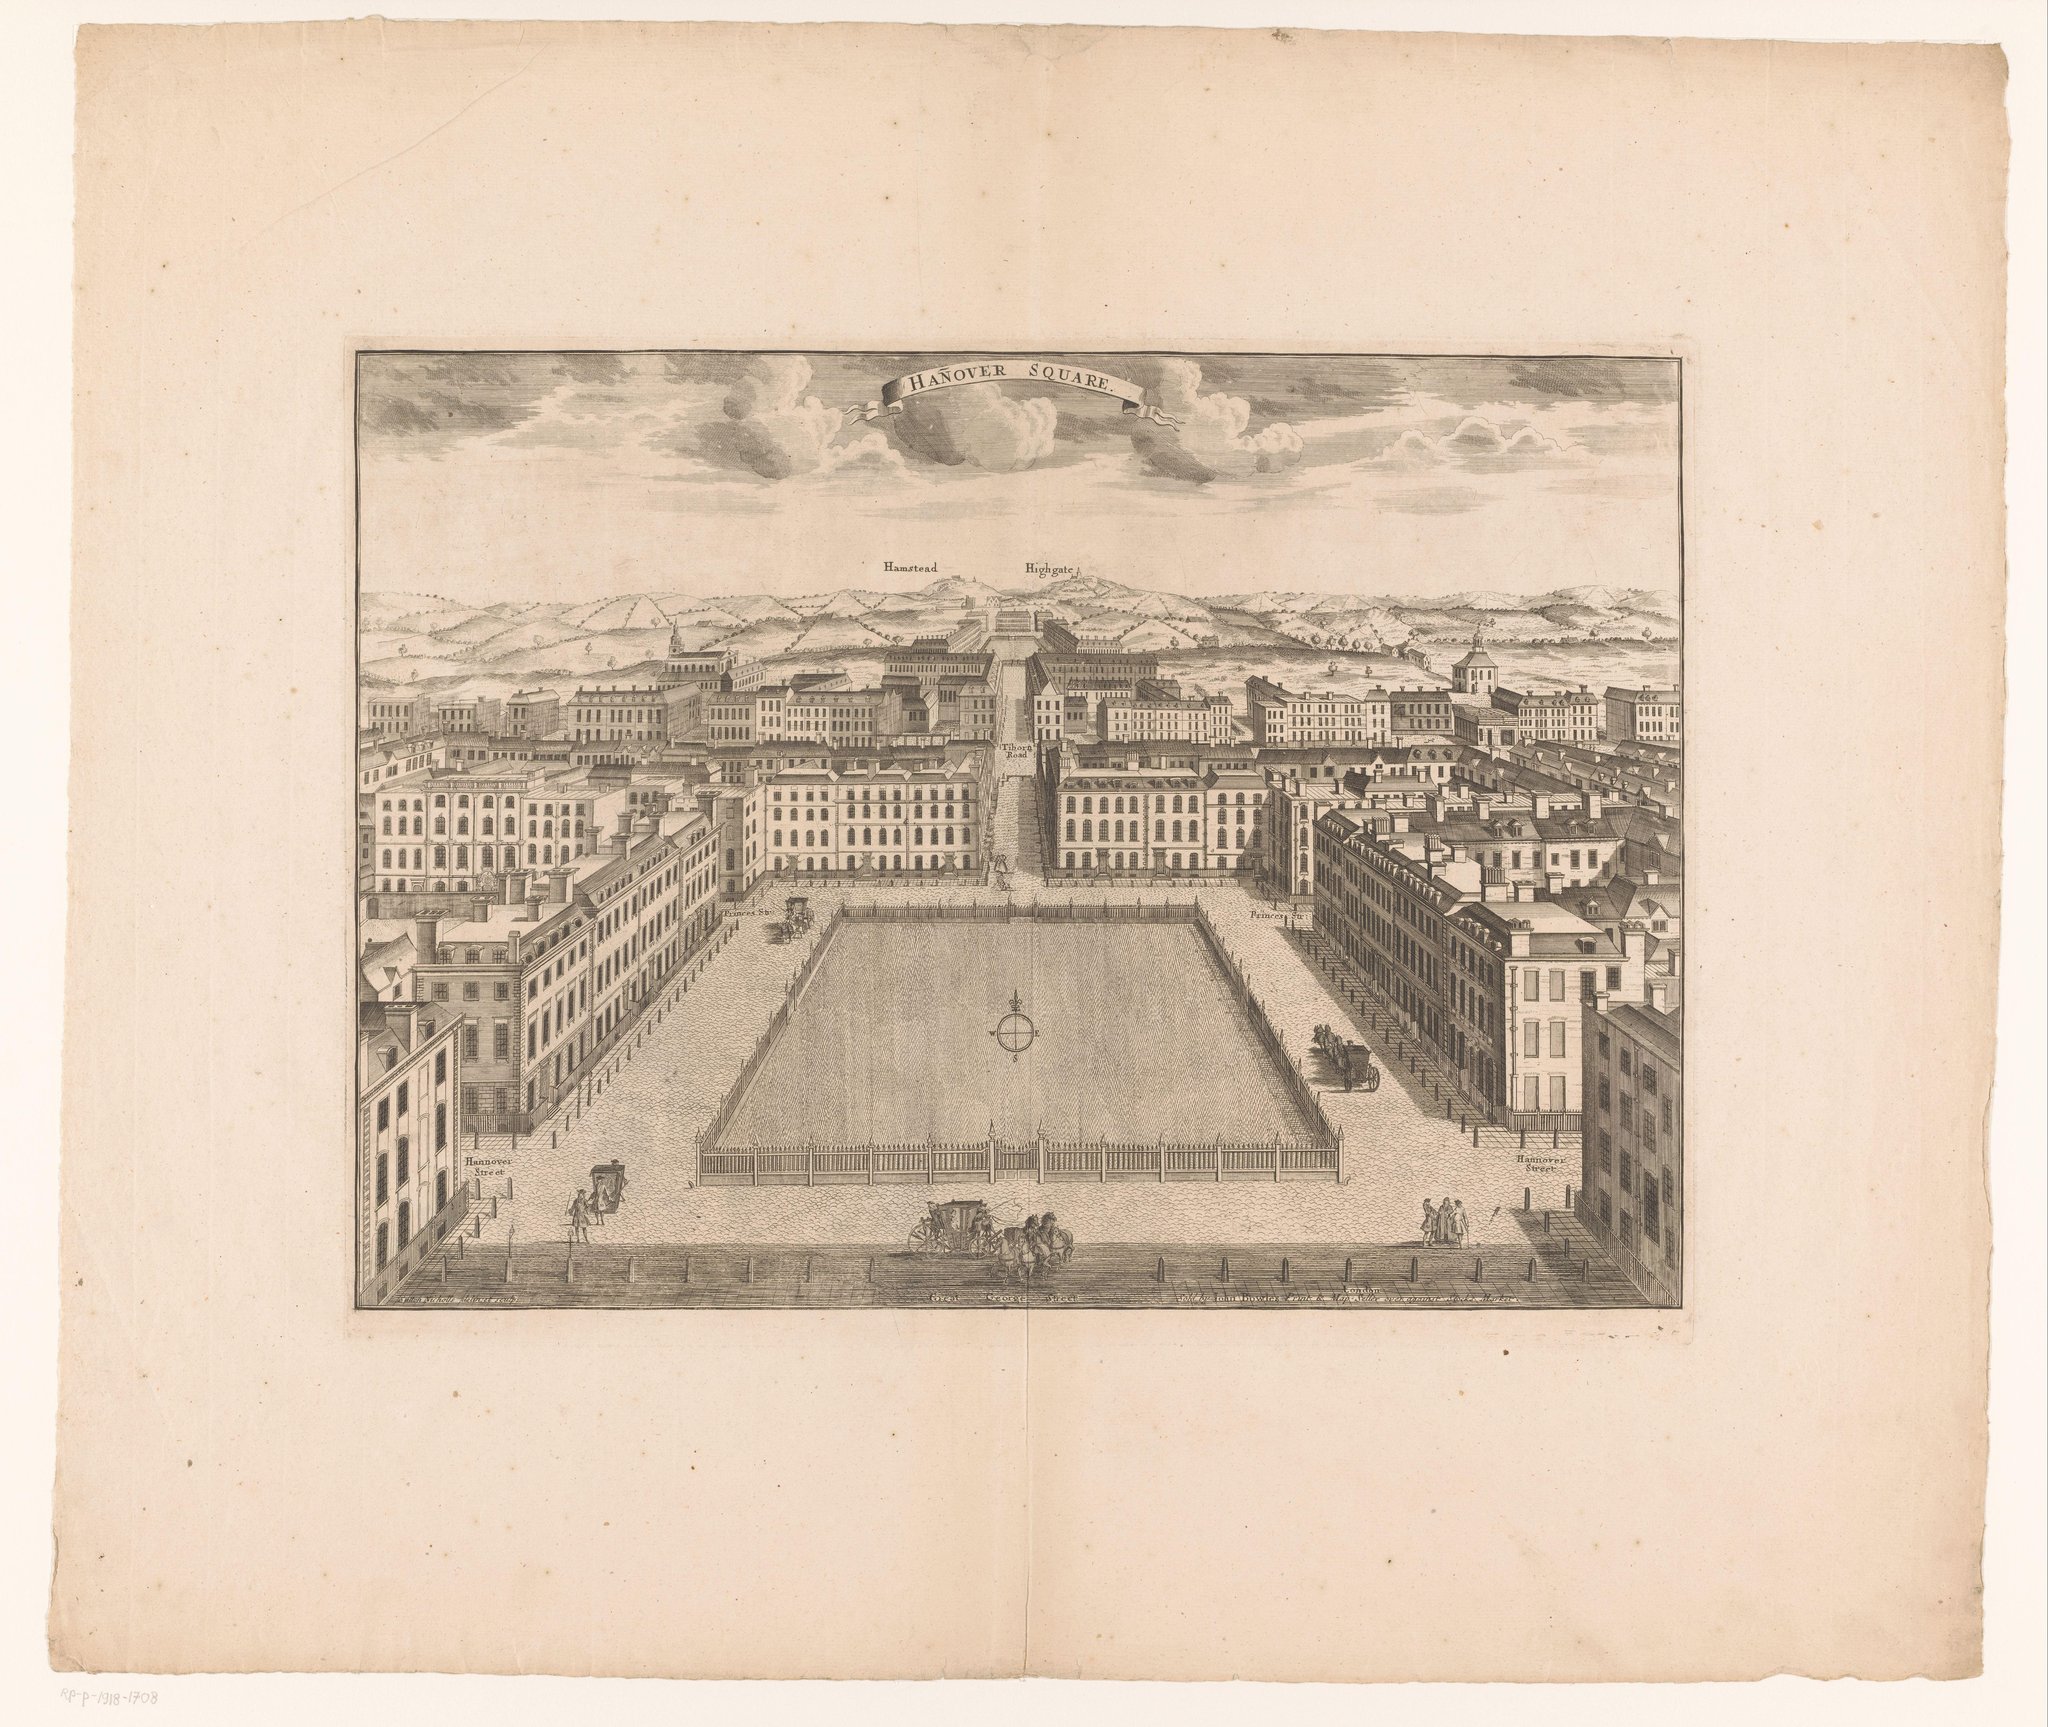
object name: print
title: Gezicht op Hanover Square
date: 1720-1731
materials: paper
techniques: engraving, etching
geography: london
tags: square, place, circus, etc.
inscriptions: collector's mark: Lugt 2233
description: Deze reeks werd voor het eerst compleet uitgegeven in 1731, al zijn de losse prenten al voor die tijd uitgebracht. De meeste prenten zijn vervaardigd door Sutton Nicholls. De serie werd aangeboden voor verkoop door John Bowles in zijn catalogus 1753, op pagina 76, nummer 16.